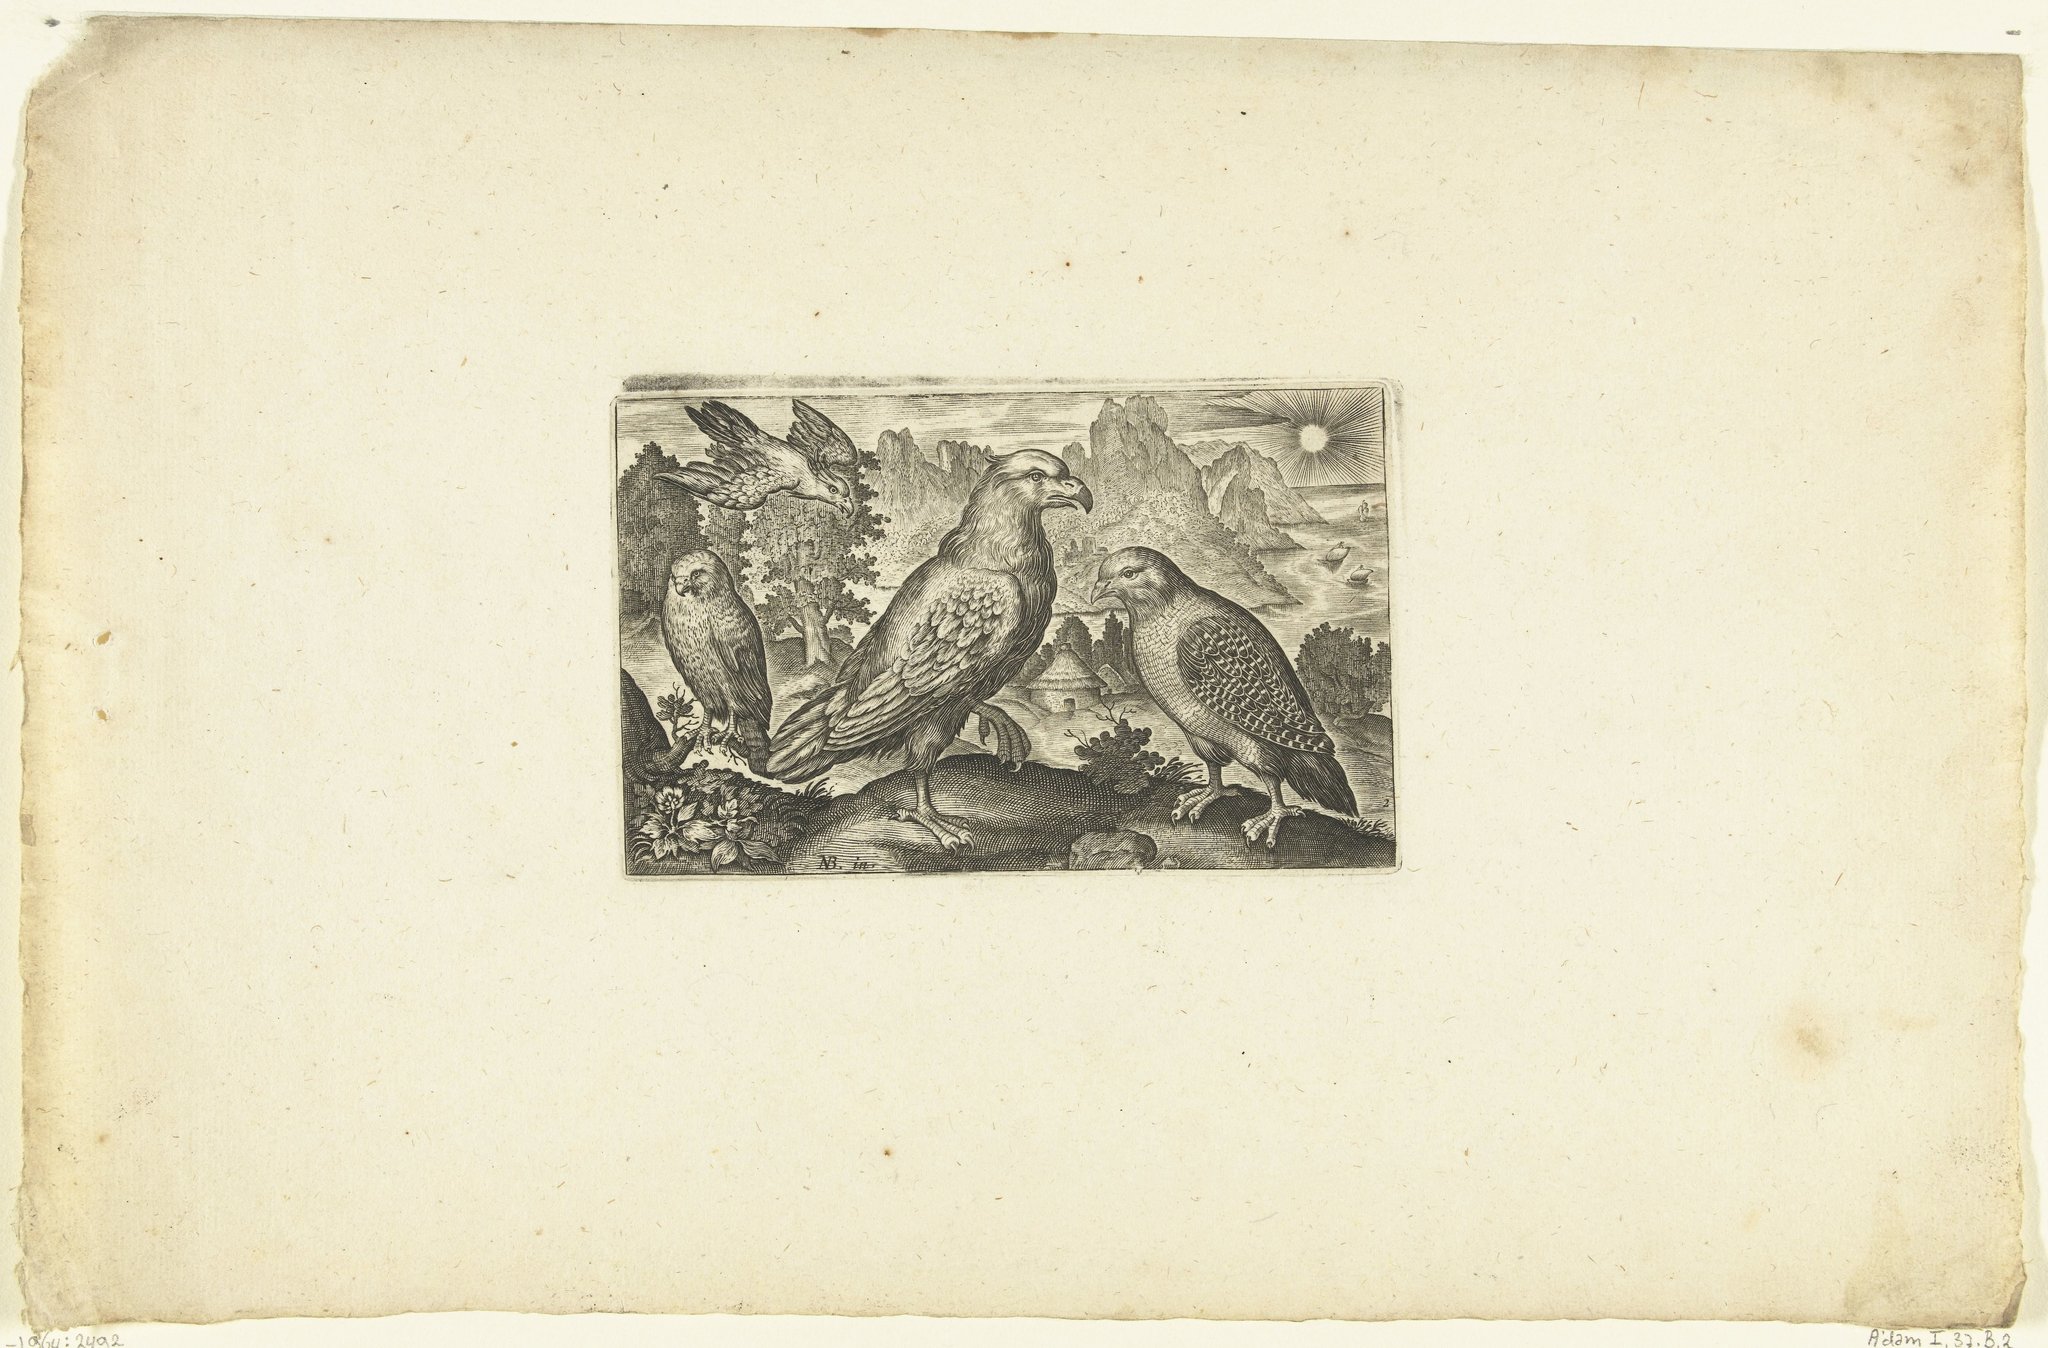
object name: ornament print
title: Arend en een patrijs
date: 1581-1652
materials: paper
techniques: engraving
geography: amsterdam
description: Kopie van prent uit de serie beschreven bij Orn Cat I-37.2